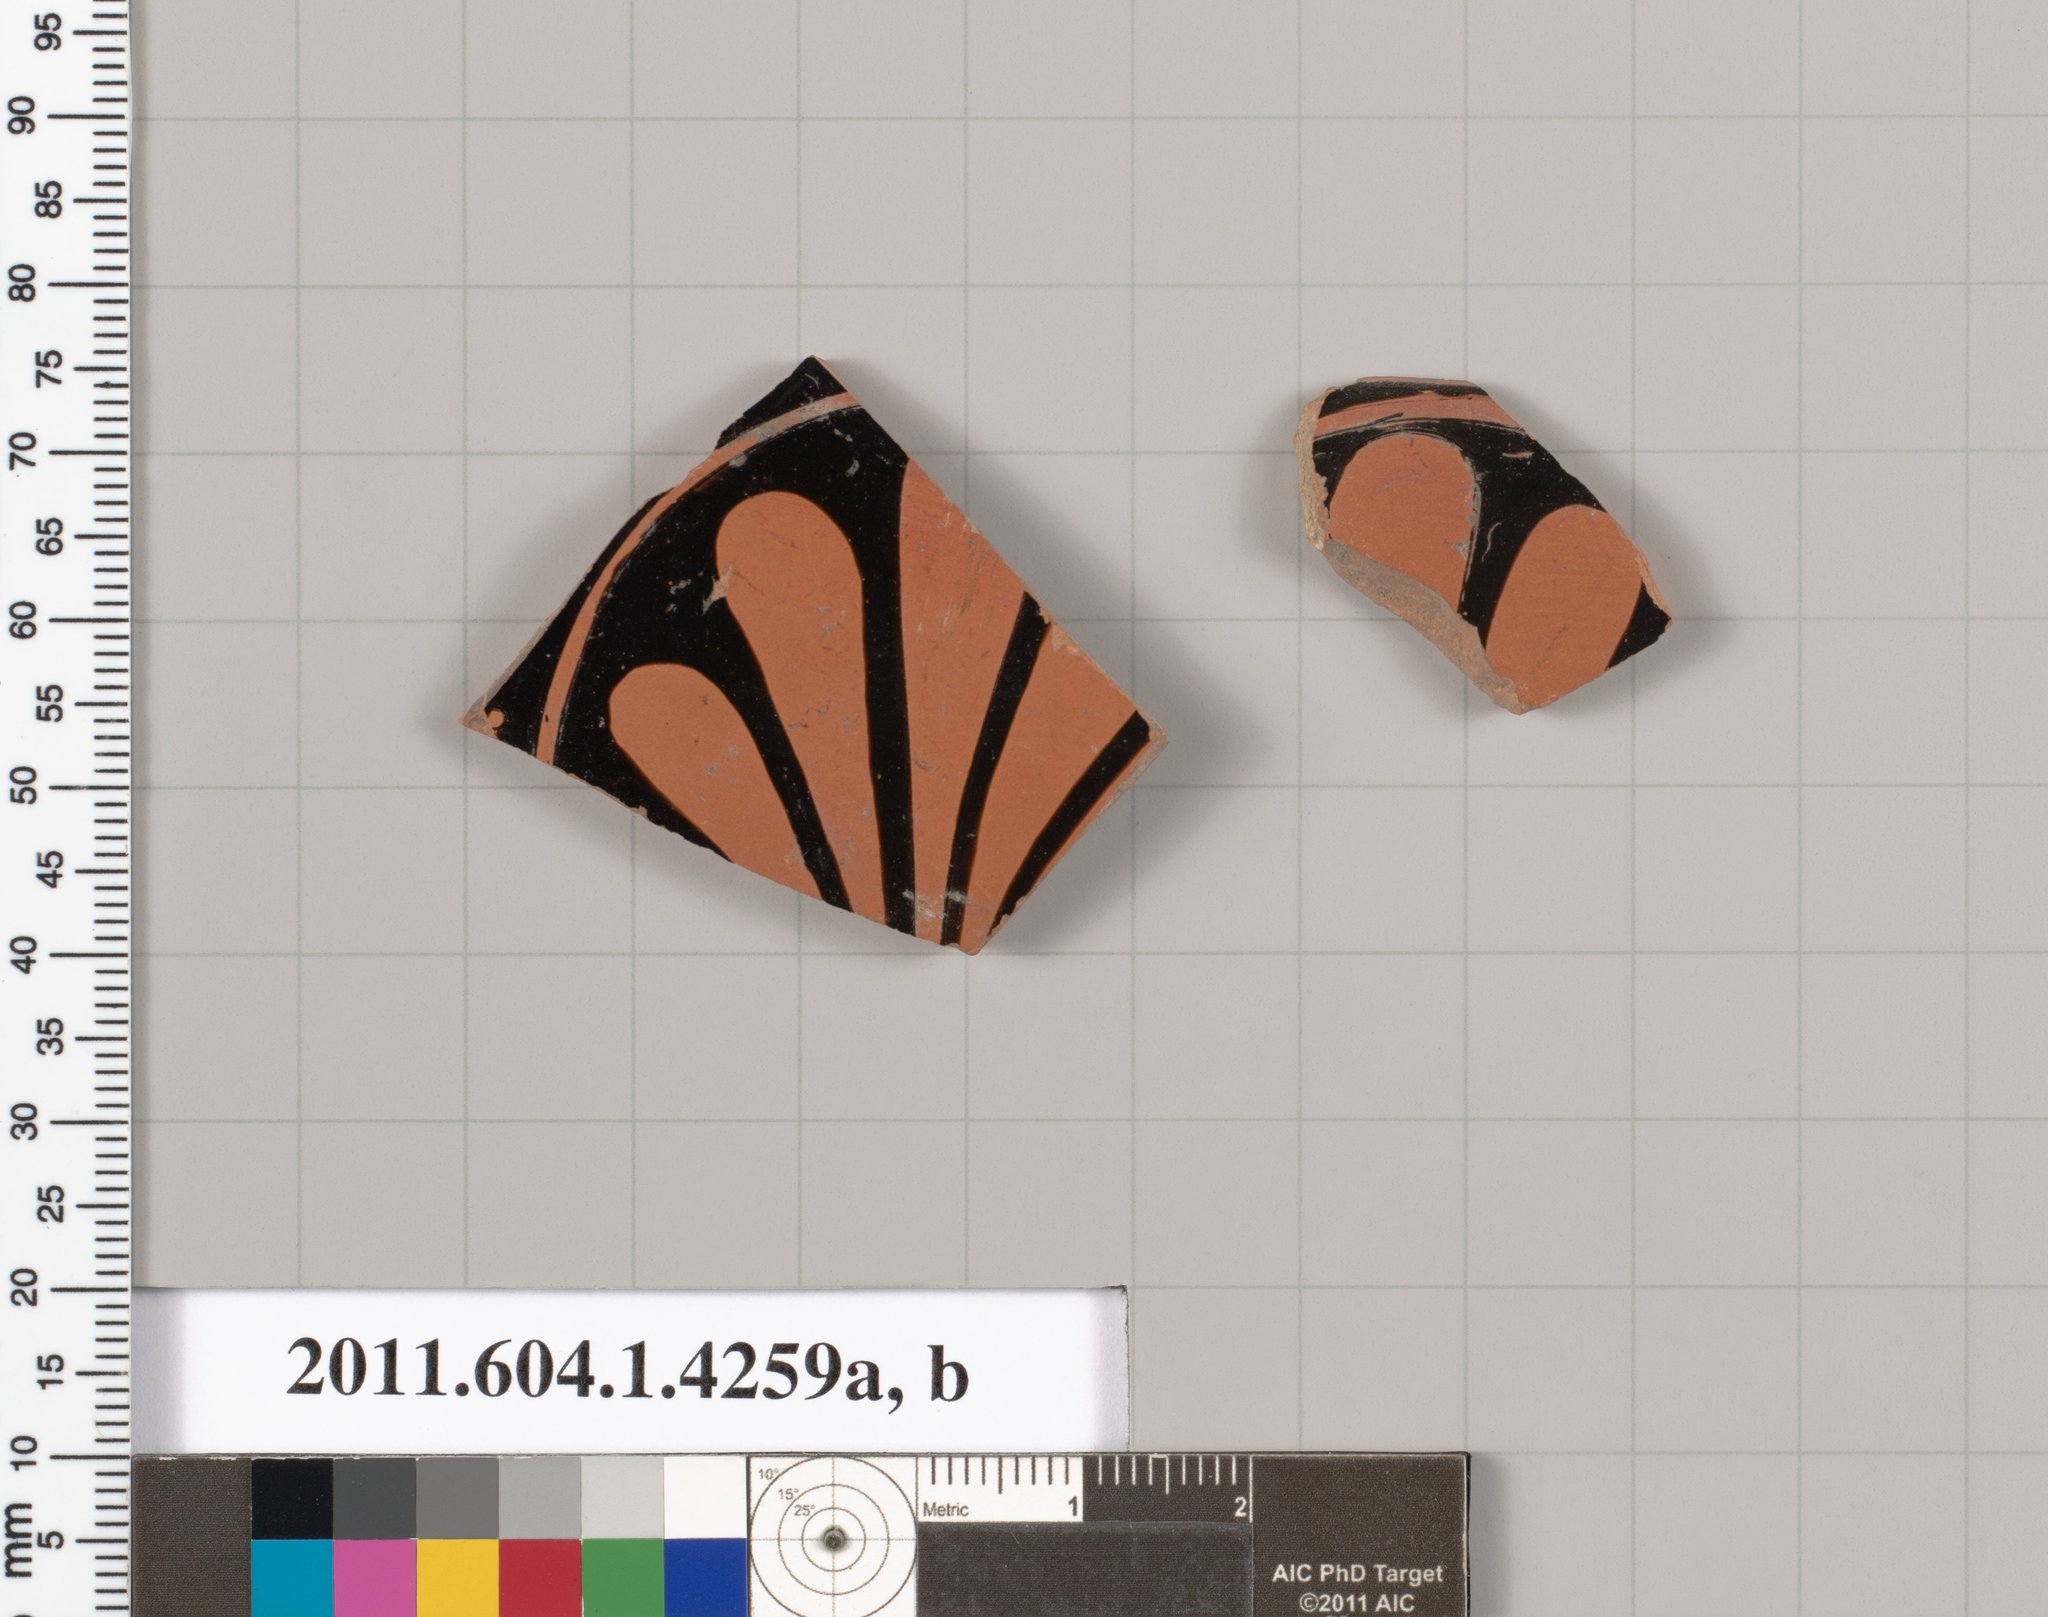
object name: kylix fragment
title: Terracotta fragments of kylikes (drinking cups)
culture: greek, attic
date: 520-500 BCE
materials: terracotta